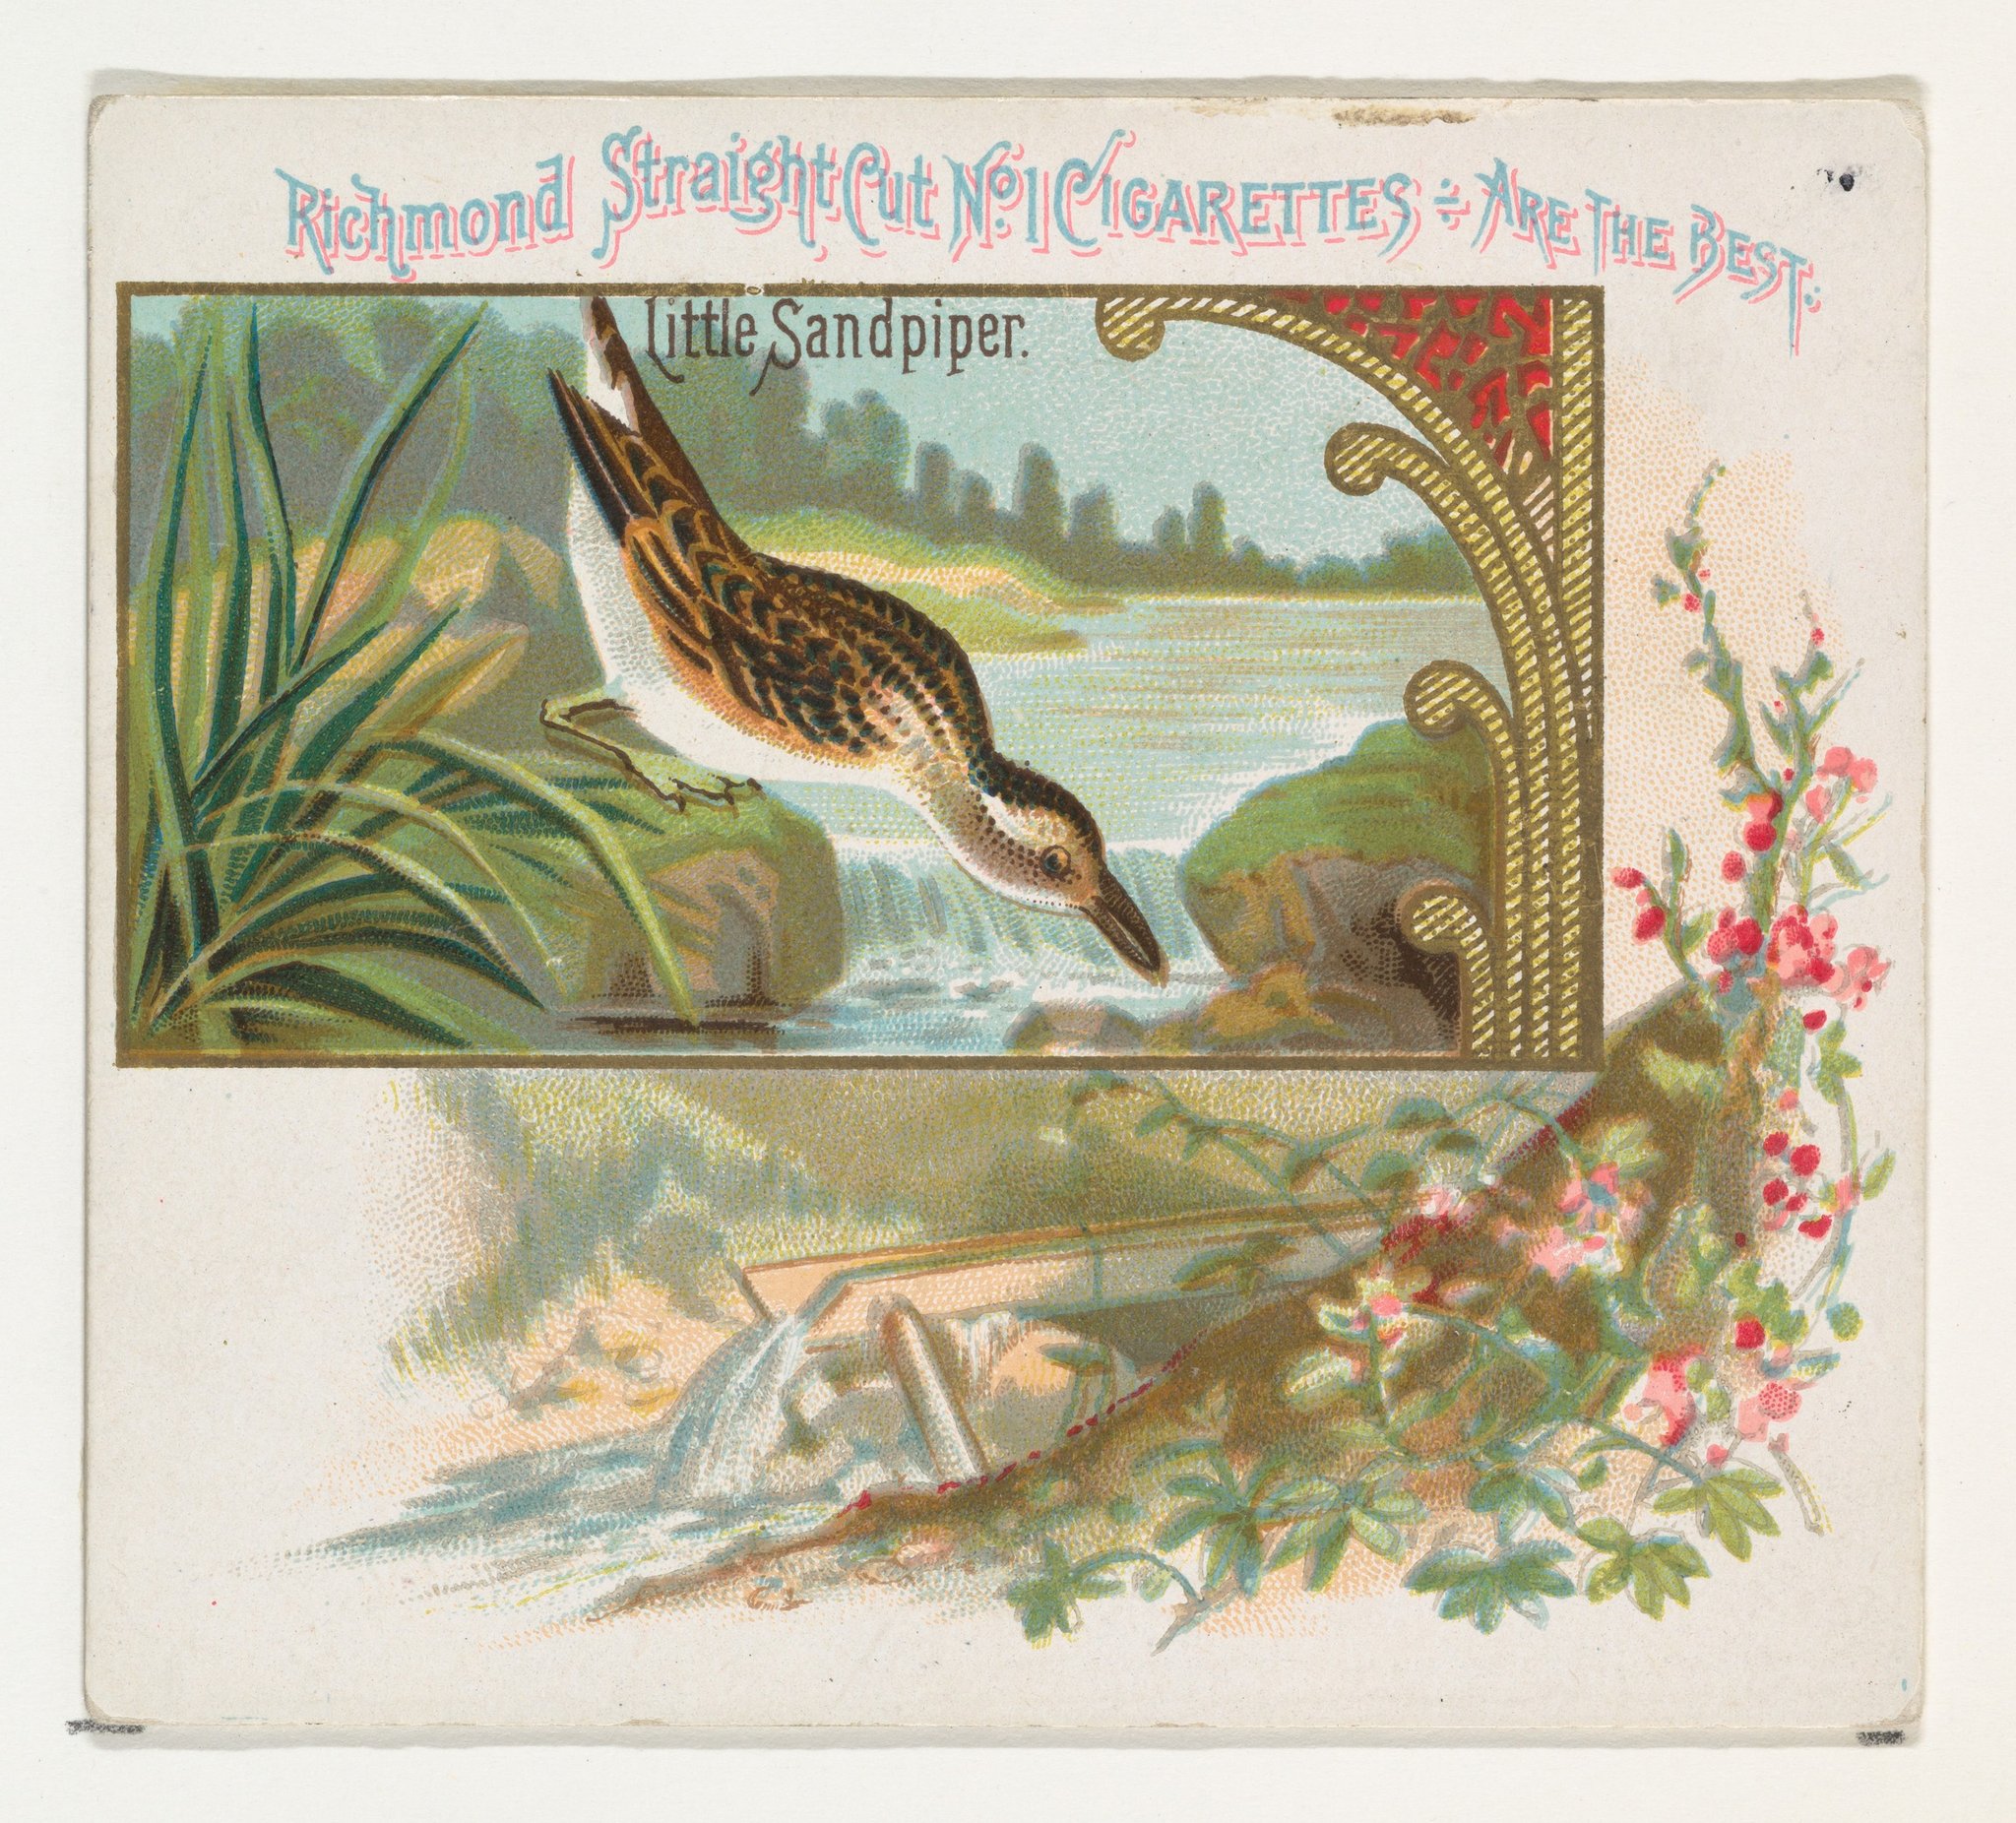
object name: print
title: Little Sandpiper, from the Game Birds series (N40) for Allen & Ginter Cigarettes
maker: allen & ginter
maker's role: publisher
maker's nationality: american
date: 1888-1890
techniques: color lithograph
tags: birds